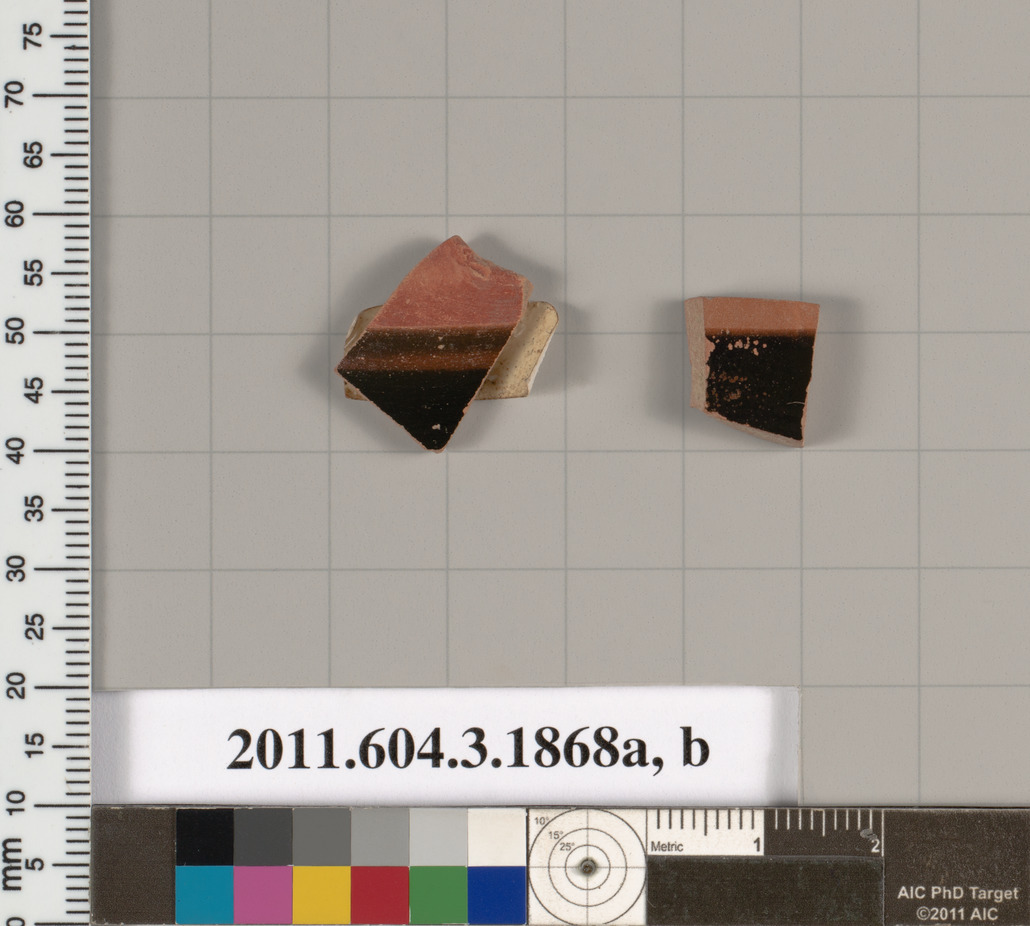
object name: kylix fragment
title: Terracotta fragments of kylikes: Band or lip cups (drinking cups)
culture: greek, attic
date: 560-525 BCE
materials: terracotta